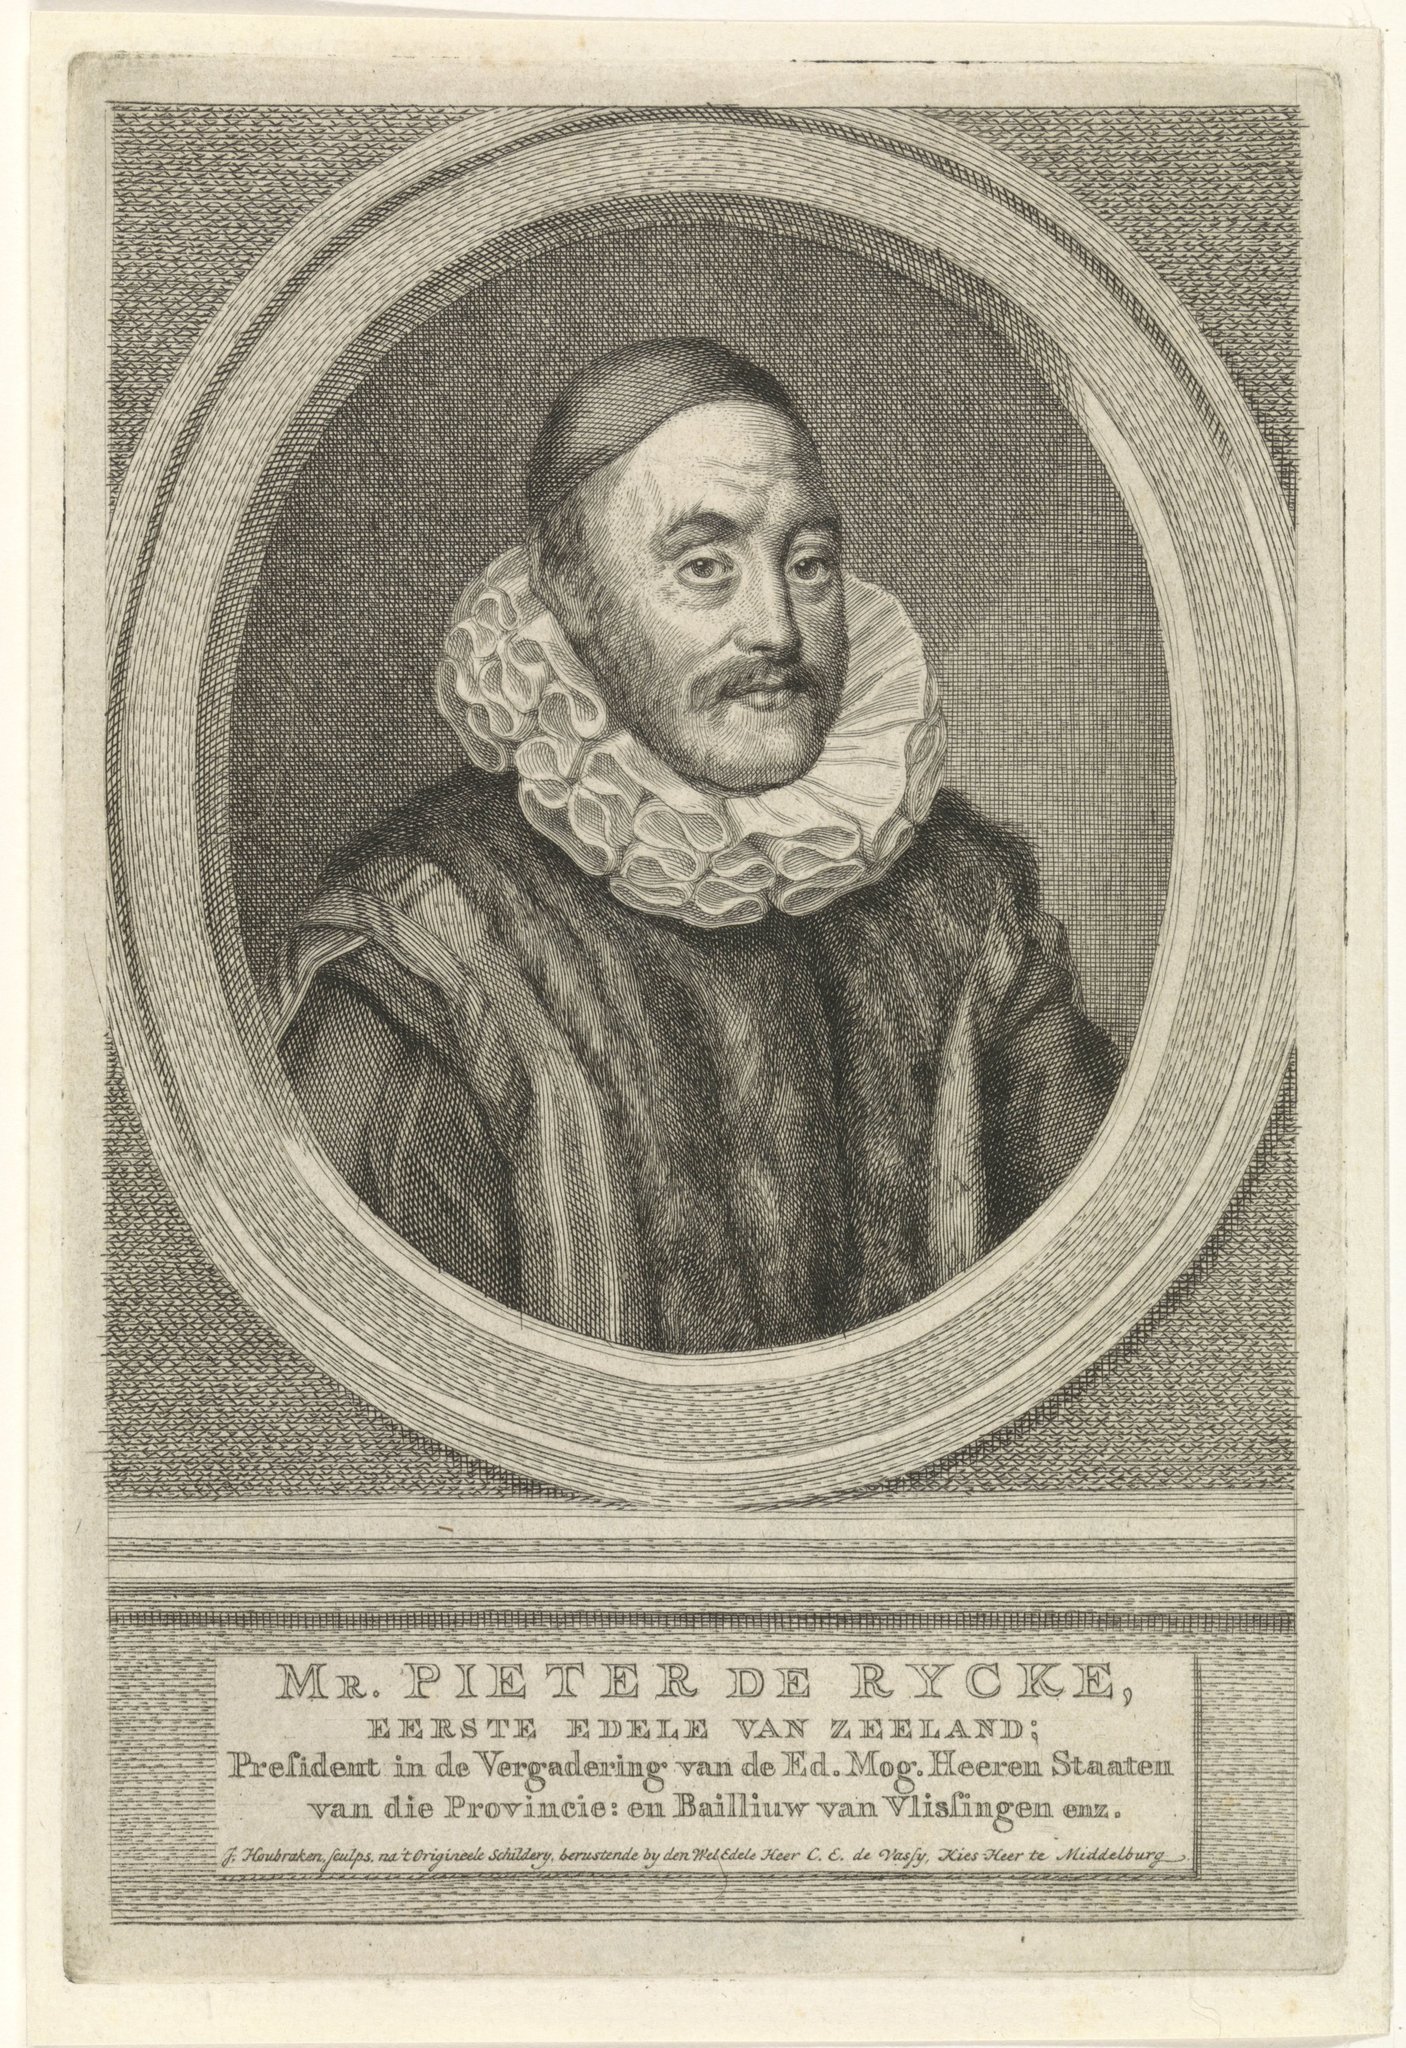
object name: print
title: Portret van Petrus Rijcke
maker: jacob houbraken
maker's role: draughtsman, print maker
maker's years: 1698-1780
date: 1749-1780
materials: paper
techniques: engraving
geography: amsterdam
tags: historical persons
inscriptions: collector's mark: Lugt 2228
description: Deze prent is oorspronkelijk bedoeld als aanvulling op Jan Wagenaars ‘Vaderlandsche historie’* en was zo vanaf 1796 verkrijgbaar bij Johannes Allart te Amsterdam. Voor de advertentie waarin Allart de 60 portretten en 7 platen, allen gegraveerd door Houbraken, ter aanvulling op Wagenaars ‘Vaderlandsche historie’ aanbiedt, zie RP-P-OB-77.766. *Van dit werk zijn in de achttiende eeuw meerdere uitgaves verschenen, zoals: Wagenaar, Jan. Vaderlandsche historie, vervattende de geschiedenissen der Vereenigde Nederlanden (…). 21 delen. Amsterdam: Isaak Tirion, 1749-1759. Wagenaar, Jan. Vaderlandsche historie, vervattende de geschiedenissen der nu Vereenigde Nederlanden (…). 21 delen. Amsterdam: weduwe Isaak Tirion, 1770. Wagenaar, Jan. Vaderlandsche historie, vervattende de geschiedenissen der nu Vereenigde Nederlanden (…). 21 delen. Amsterdam, Leiden, Dordrecht en Harlingen: P. Schouten e.a., 1782. Wagenaar, Jan. Vaderlandsche historie, vervattende de geschiedenissen der nu Vereenigde Nederlanden (…). 21 delen. Amsterdam: Johannes Allart, 1790-1796.